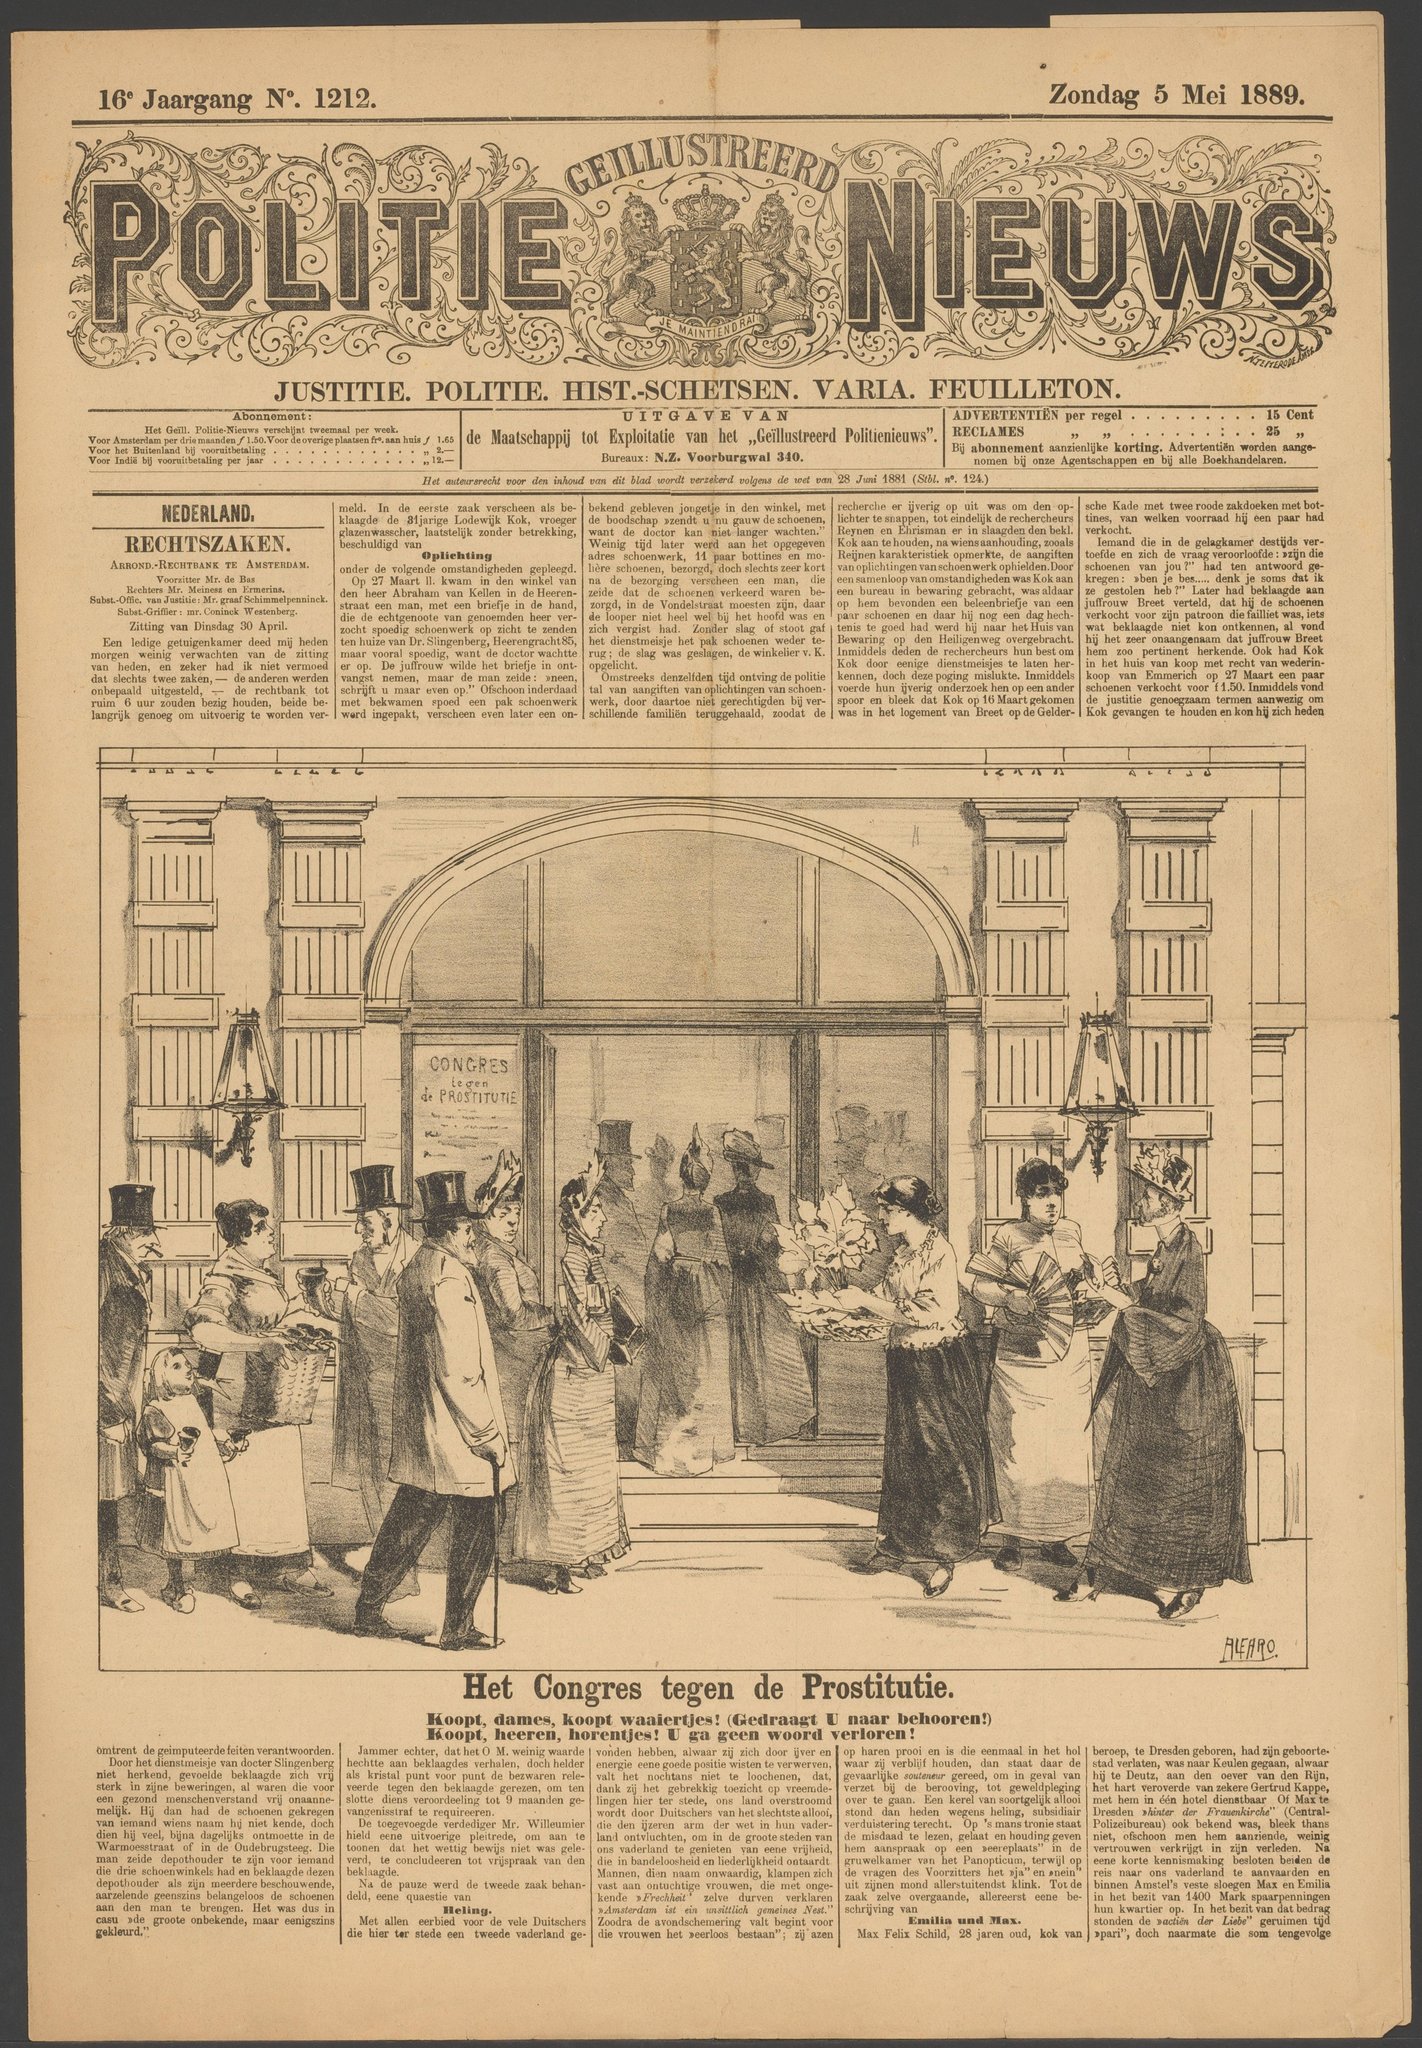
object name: newspaper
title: Geïllustreerd Politienieuws, 5 mei 1889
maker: alfaro reijding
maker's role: draughtsman, engineer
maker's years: 1863-1930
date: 1889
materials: paper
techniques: lithograph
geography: amsterdam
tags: newspaper, news-sheet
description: Exemplaar van de krant 'Geïllustreerd Politienieuws' van 5 mei 1889. Op de voorpagina een spotprent over 'Het Congres tegen de Prostitutie'. Dubbelbladig, alle zijden bedrukt. Uit het achterste blad is een stuk geknipt. Onderwerpsrubrieken binnen de Atlas Zeden en Gewoonten: Regeering, Officieele Nieuwsbladen.